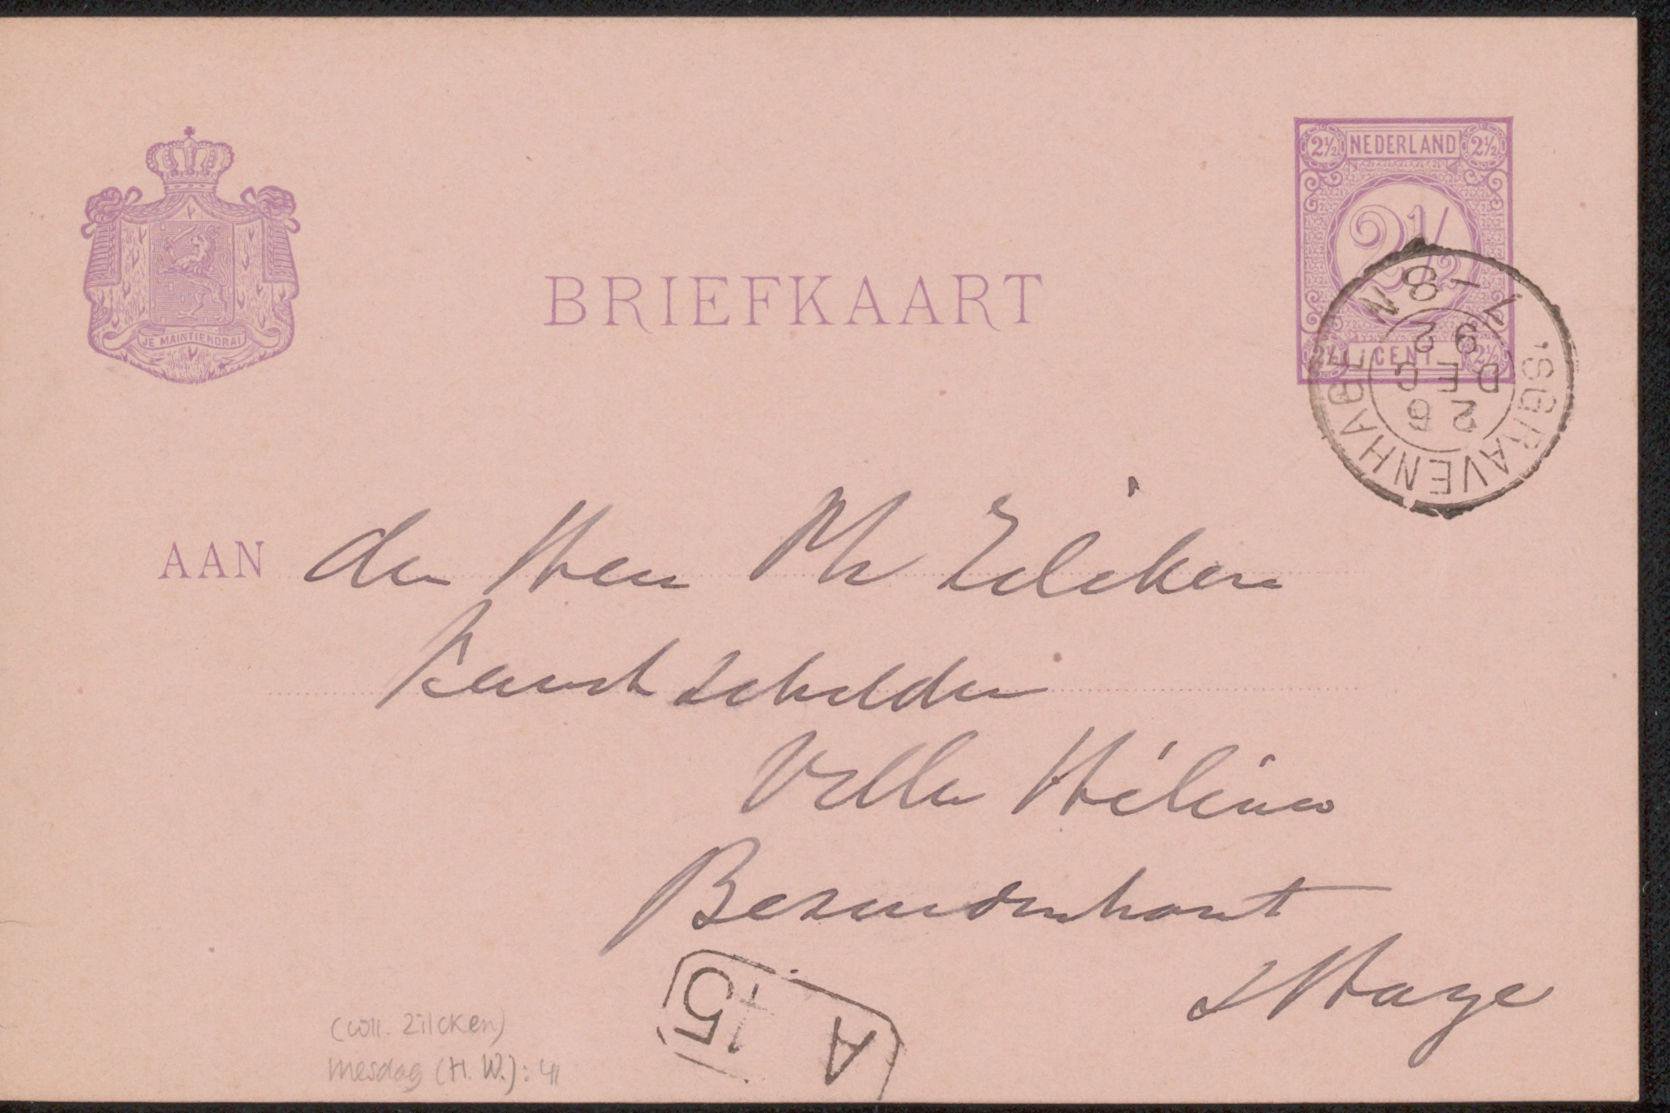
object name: postcard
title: Briefkaart aan Philip Zilcken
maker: hendrik willem mesdag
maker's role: draughtsman, painter, print maker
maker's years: 1831-1915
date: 1892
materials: cardboard, ink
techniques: pen, writing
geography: the hague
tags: london, matthijs maris, philip zilcken, drawing, the graphic arts